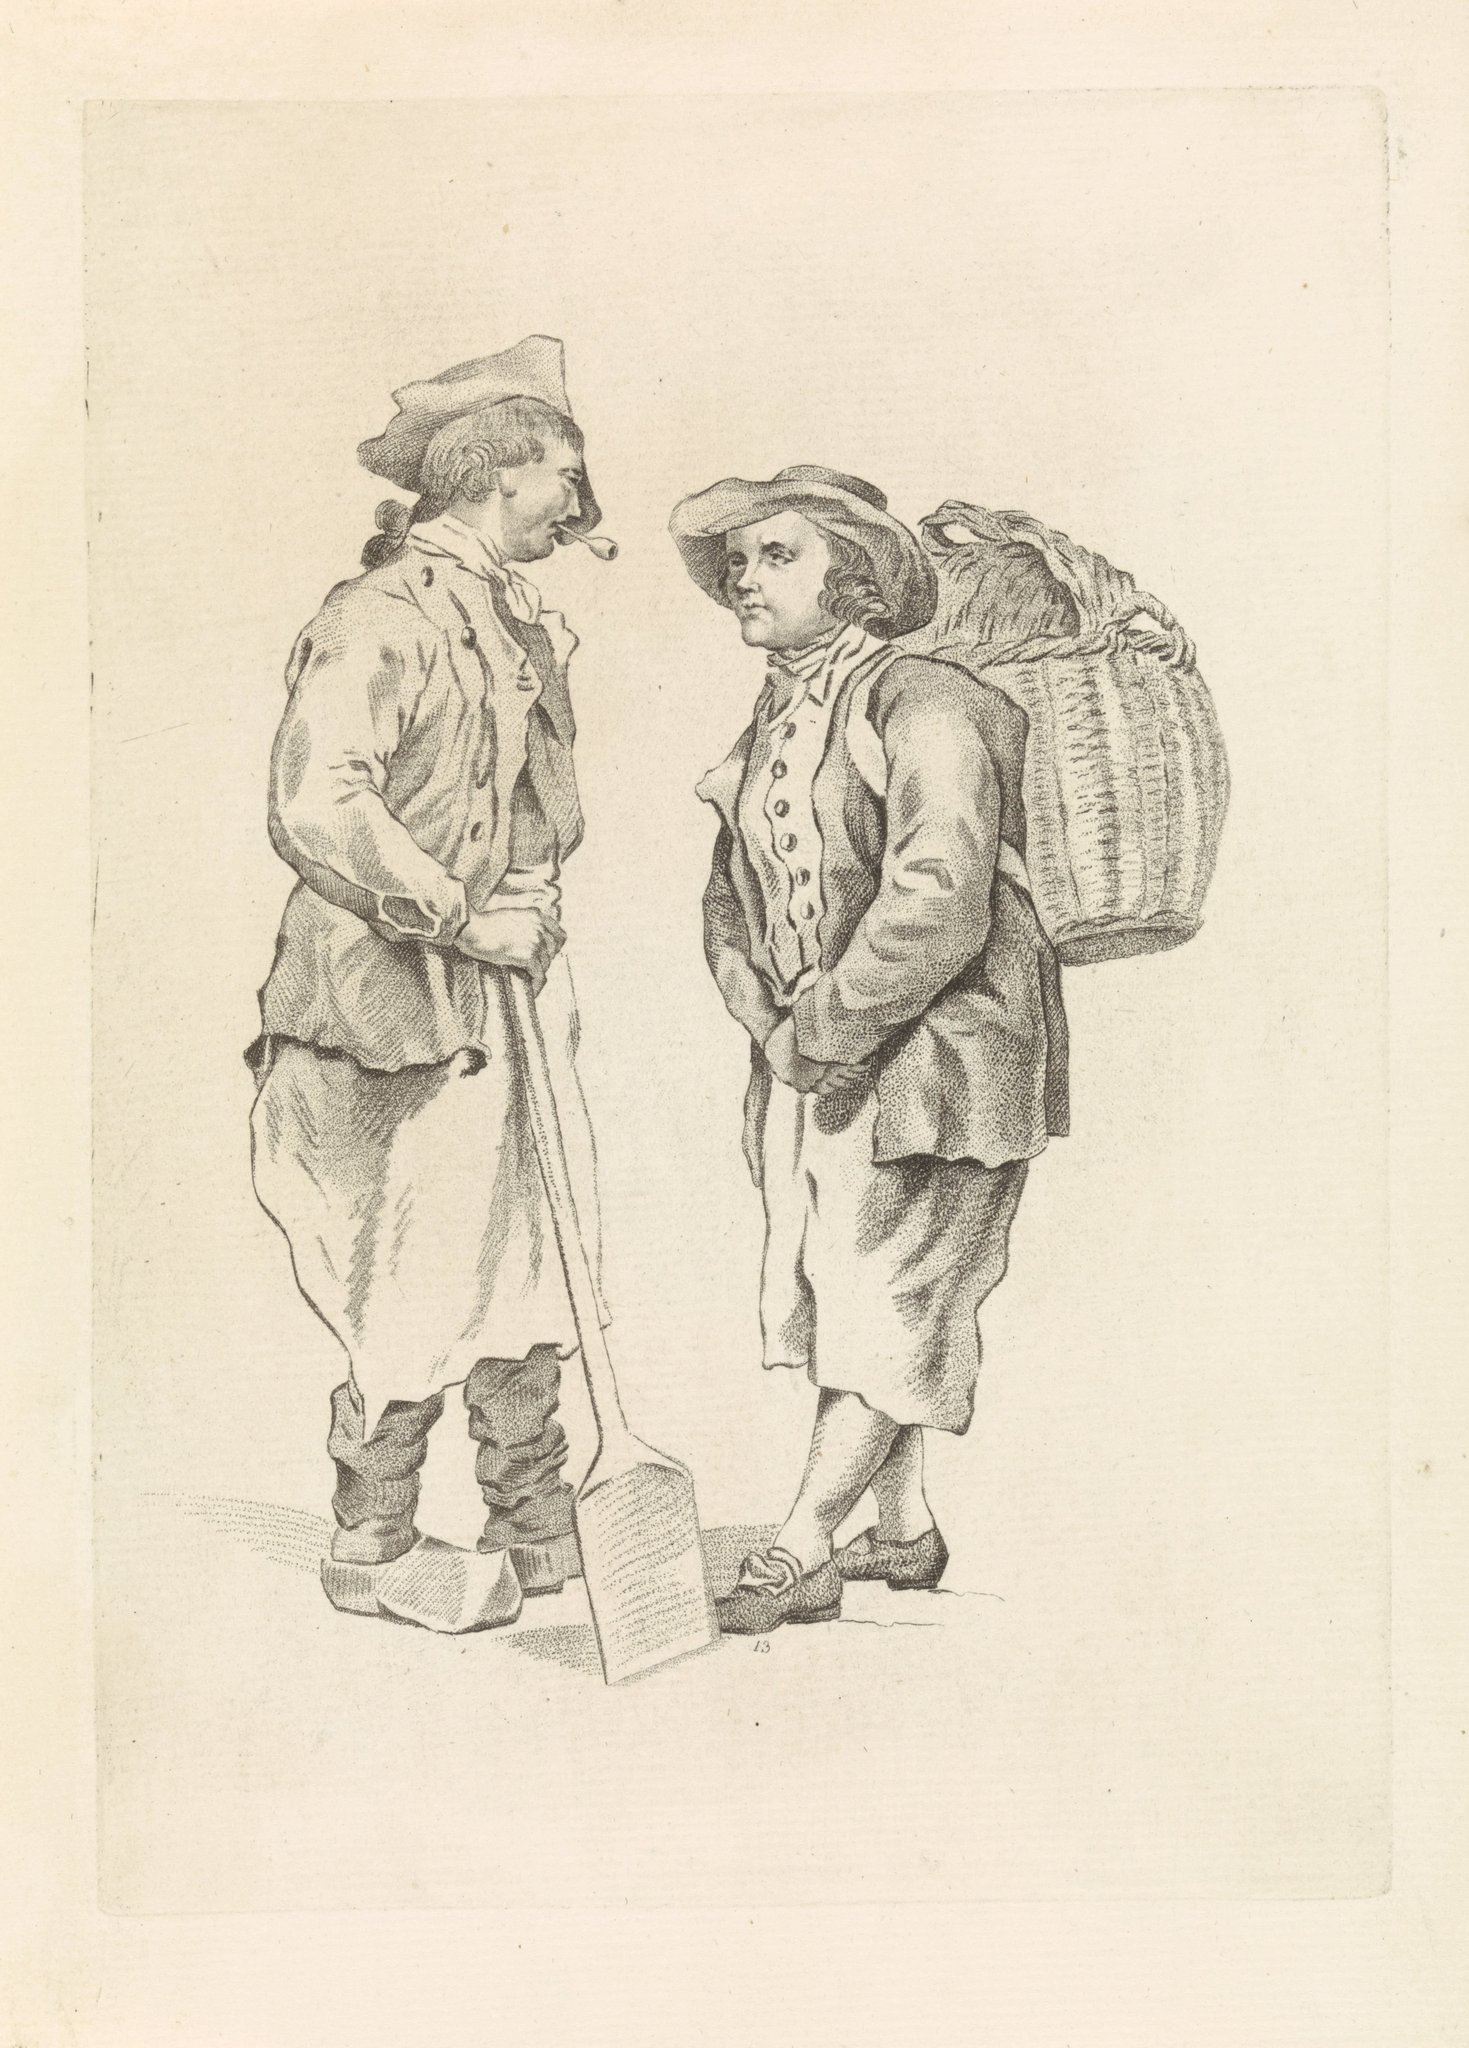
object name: print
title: Twee boeren in gesprek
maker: mathias de sallieth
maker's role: print maker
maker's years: 1749-1791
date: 1772-1791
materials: paper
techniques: printmaking, etching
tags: pipe ~ tobacco, farmers, carrying something in basket, bag, rucksack, etc., agricultural implements: spade, conversation, dialogue; conversation piece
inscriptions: collector's mark: Lugt 2228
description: De prent verscheen vanaf 1818 tevens als onderdeel van een 33-delige reeks prenten door Mathias de Sallieth, samengebonden in: Perkois, Jacobus, Prins, Johannes Huibert. Verzameling van verschillende gekleede mans- en vrouwenstanden, ter oefening van jonge schilders en liefhebbers. Rotterdam: Johannes Immerzeel, 1818.